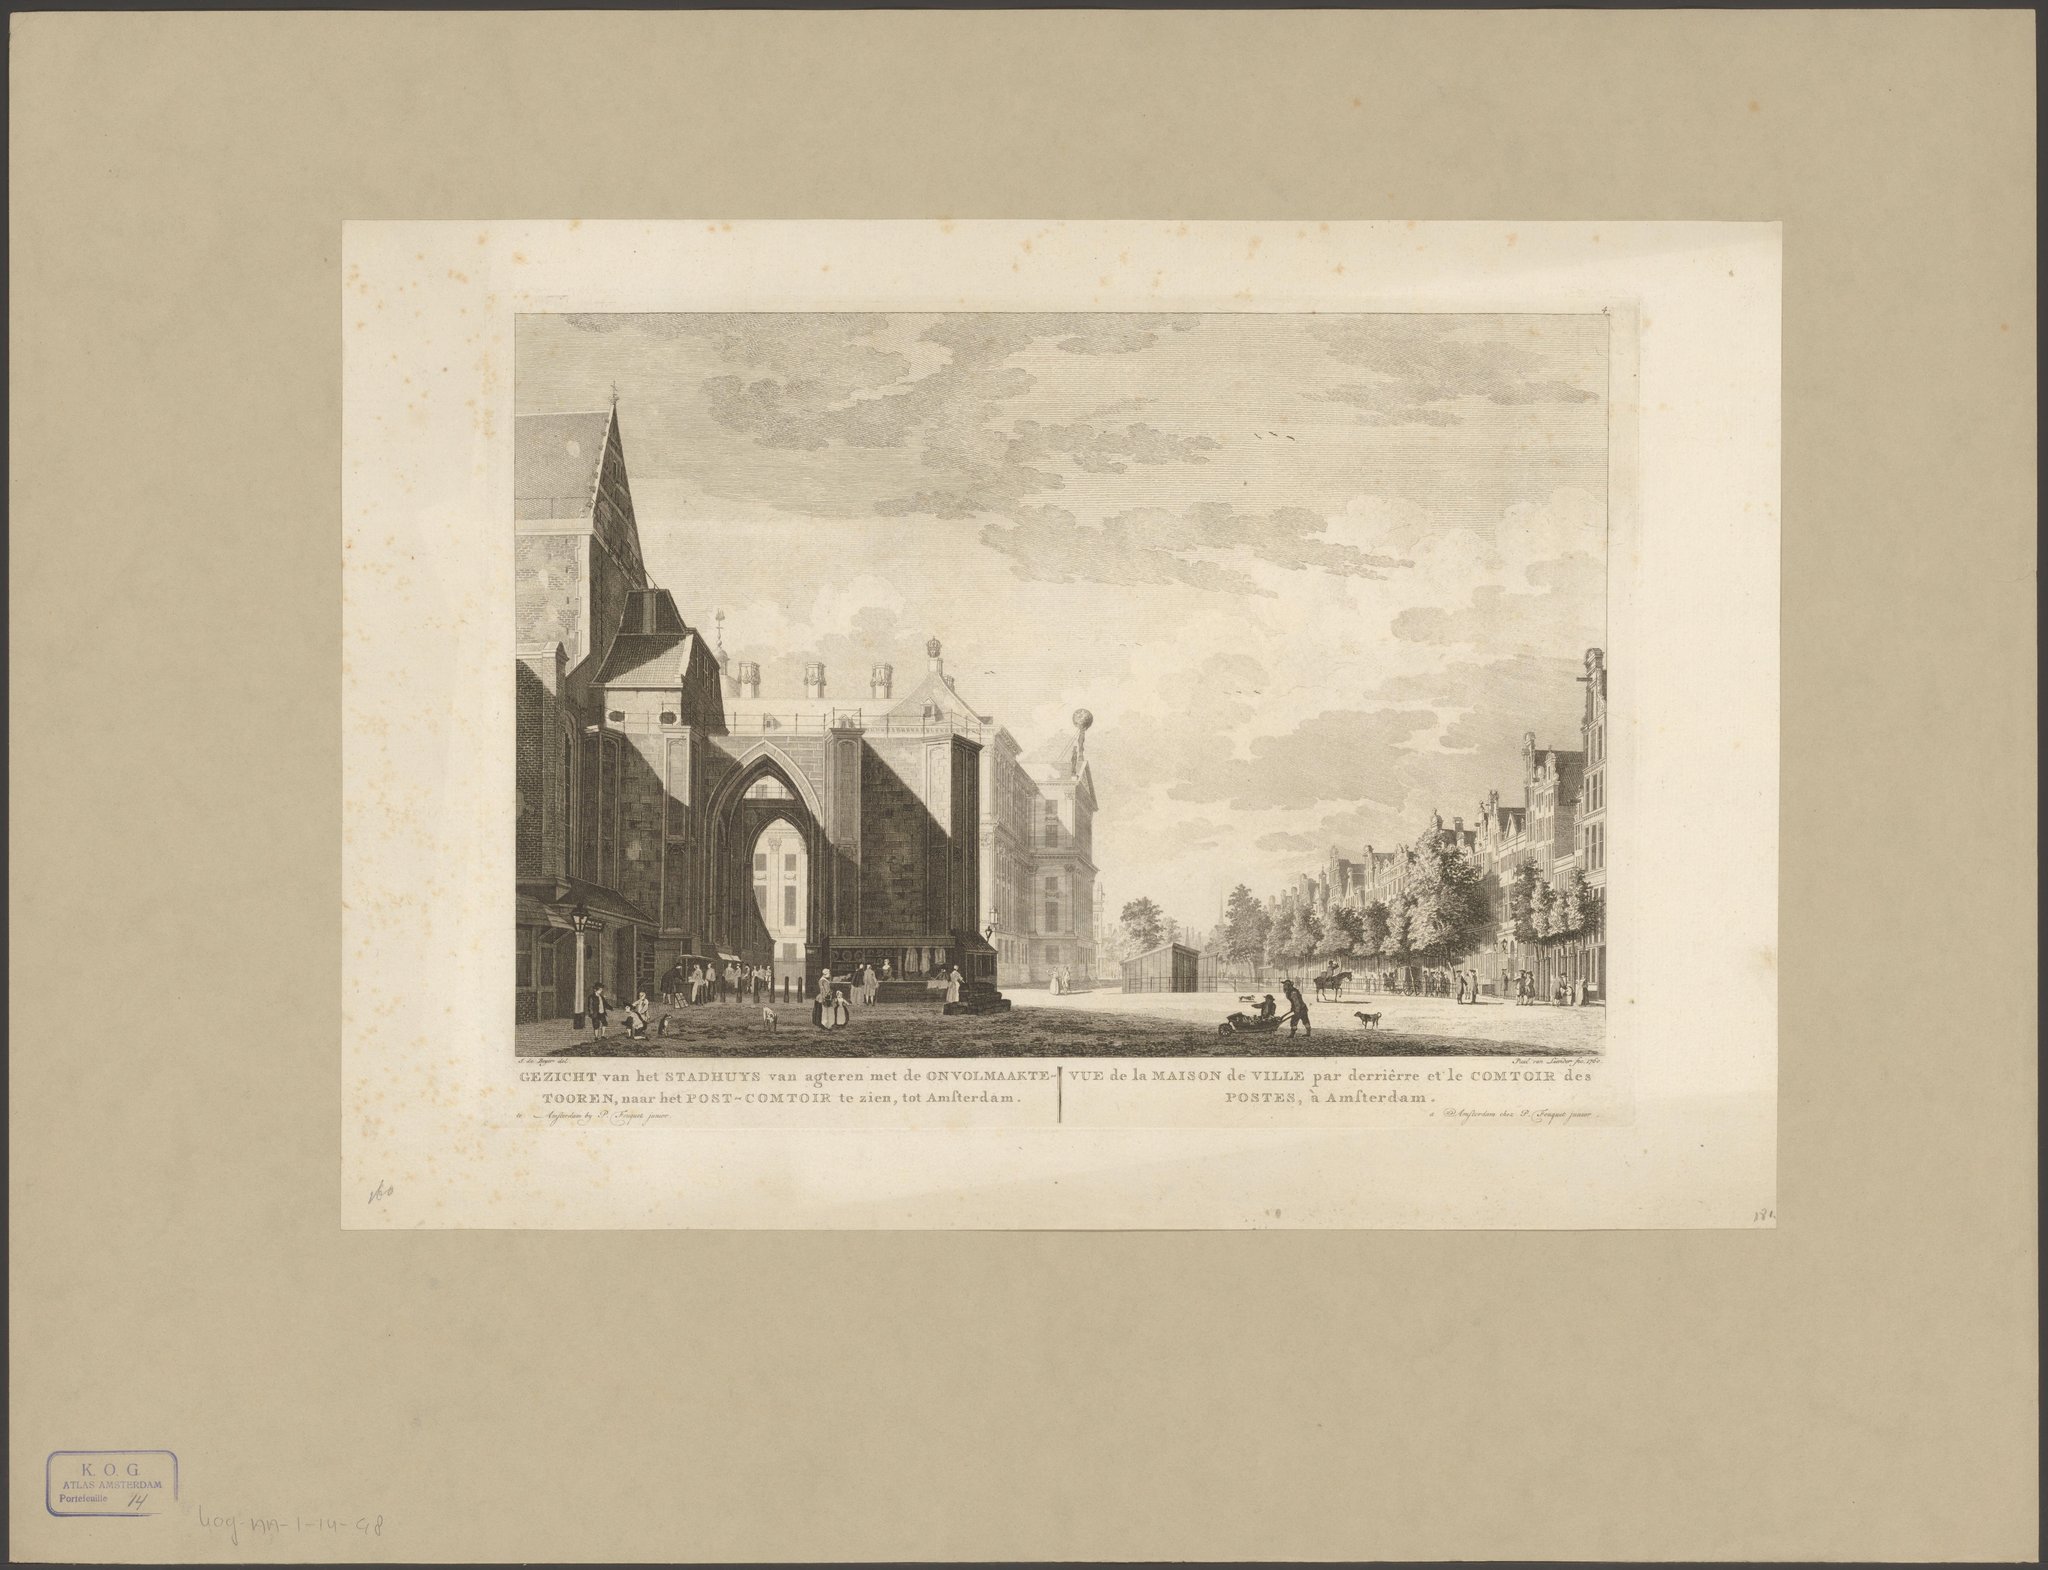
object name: print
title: Gezicht op de Nieuwezijds Voorburgwal met de achterkant van de Nieuwe Kerk en het Stadhuis op de Dam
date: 1788-1801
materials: paper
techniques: etching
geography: amsterdam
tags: post-office, city-view in general; 'veduta', church (exterior), townhall, street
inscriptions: collector's mark: ‘14’ Lugt 1641b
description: Deze prent is ook gebruikt in de zogenaamde Atlas van Fouquet.* Pierre Fouquet gaf vanaf 1760 stadsgezichten van Amsterdam - naar tekeningen van verschillende kunstenaars, gemaakt door verschillende prentmakers - uit. Deze prenten werden aanvankelijk los of in series verkocht. Zoals toen gebruikelijk kon de koper de prenten zelf laten inbinden. Hiertoe gaf Fouquet tussen 1778 en 1783 een titelblad, plattegrond en inhoudsopgave van de tot dusver 100 uitgegeven prenten uit (1). Gezien de inhoud afhankelijk was van wat de koper had verzameld verschilt de inhoud van de verschillende bewaarde Fouquetatlassen onder deze titel sterk. Ook zijn er exemplaren bekend waar tevens andere prenten aan zijn toegevoegd. Omdat er behoefte bleek aan uitleg bij de platen werd in 1783 een nieuwe versie van de atlas uitgegeven, aangevuld met tekst en twee prenten. De aangegeven volgorde veranderde maar de platen van de al eerder uitgegeven prenten bleven ongewijzigd. Deze uitgave werd in opdracht van Fouquet gedrukt bij Daniël Jean Changuion en Petrus den Hengst (2). Een tiental platen werd bijgewerkt en verscheen, met nieuw impressum, in het vervolg van Wagenaars geschiedenis van Amsterdam, uitgeven door Petrus Conradi en Folkert van der Plaats (3). Een aantal jaar na het overlijden van Fouquet kwam Evert Maaskamp met een nieuwe uitgave van de atlas, met verbeterde tekst en toevoeging van twee prenten. Op alle platen verwijderde hij het oude en liet hij zijn eigen impressum zetten (4). De huidige staat van de prent komt voor in exemplaren van de onder (3) genoemde werken. * Onder de Atlas van Fouquet of Fouquetatlas verstaan we de hieronder vermelde publicaties (1), (2) en (4). (1). Afbeeldingen van de wyd-vermaarde koopstad Amsterdam benevens des zelvs voornaamste gebouwen en gezigten alle naar het leeven getekend / Receuil des edifices les plus considerables et des plus belles vues, de la fameuse ville d'Amsterdam, dessinées d'après nature. Amsterdam: Pierre Fouquet, 1778-1783. (2). Nieuwe atlas, van de voornaamste gebouwen en gezigten der stad Amsterdam, met derzelver beknopte beschryvingen. 2 delen. Amsterdam: Daniël Jean Changuion en Petrus den Hengst [in opdracht van Pierre Fouquet], 1783. (3). Stijl, Simon. Amsterdam, in zyne geschiedenissen, voorregten, koophandel, gebouwen, kerkenstaat, schoolen, schutterye, gilden en regeeringe, beschreeven. Om te dienen ten vervolge op het werk van Jan Wagenaar (…). 10 delen. Amsterdam en Harlingen: Petrus Conradi en Folkert van der Plaats, 1788-1801. (4). Nieuwe atlas, van de voornaamste gebouwen en gezigten der stad Amsterdam. Met derzelver beknopte beschryvingen. Amsterdam: Evert Maaskamp, 1805. * Het aantal vermelde staten is gebaseerd op het aantal gevonden staten. Mogelijk zijn er meer staten van deze prent.